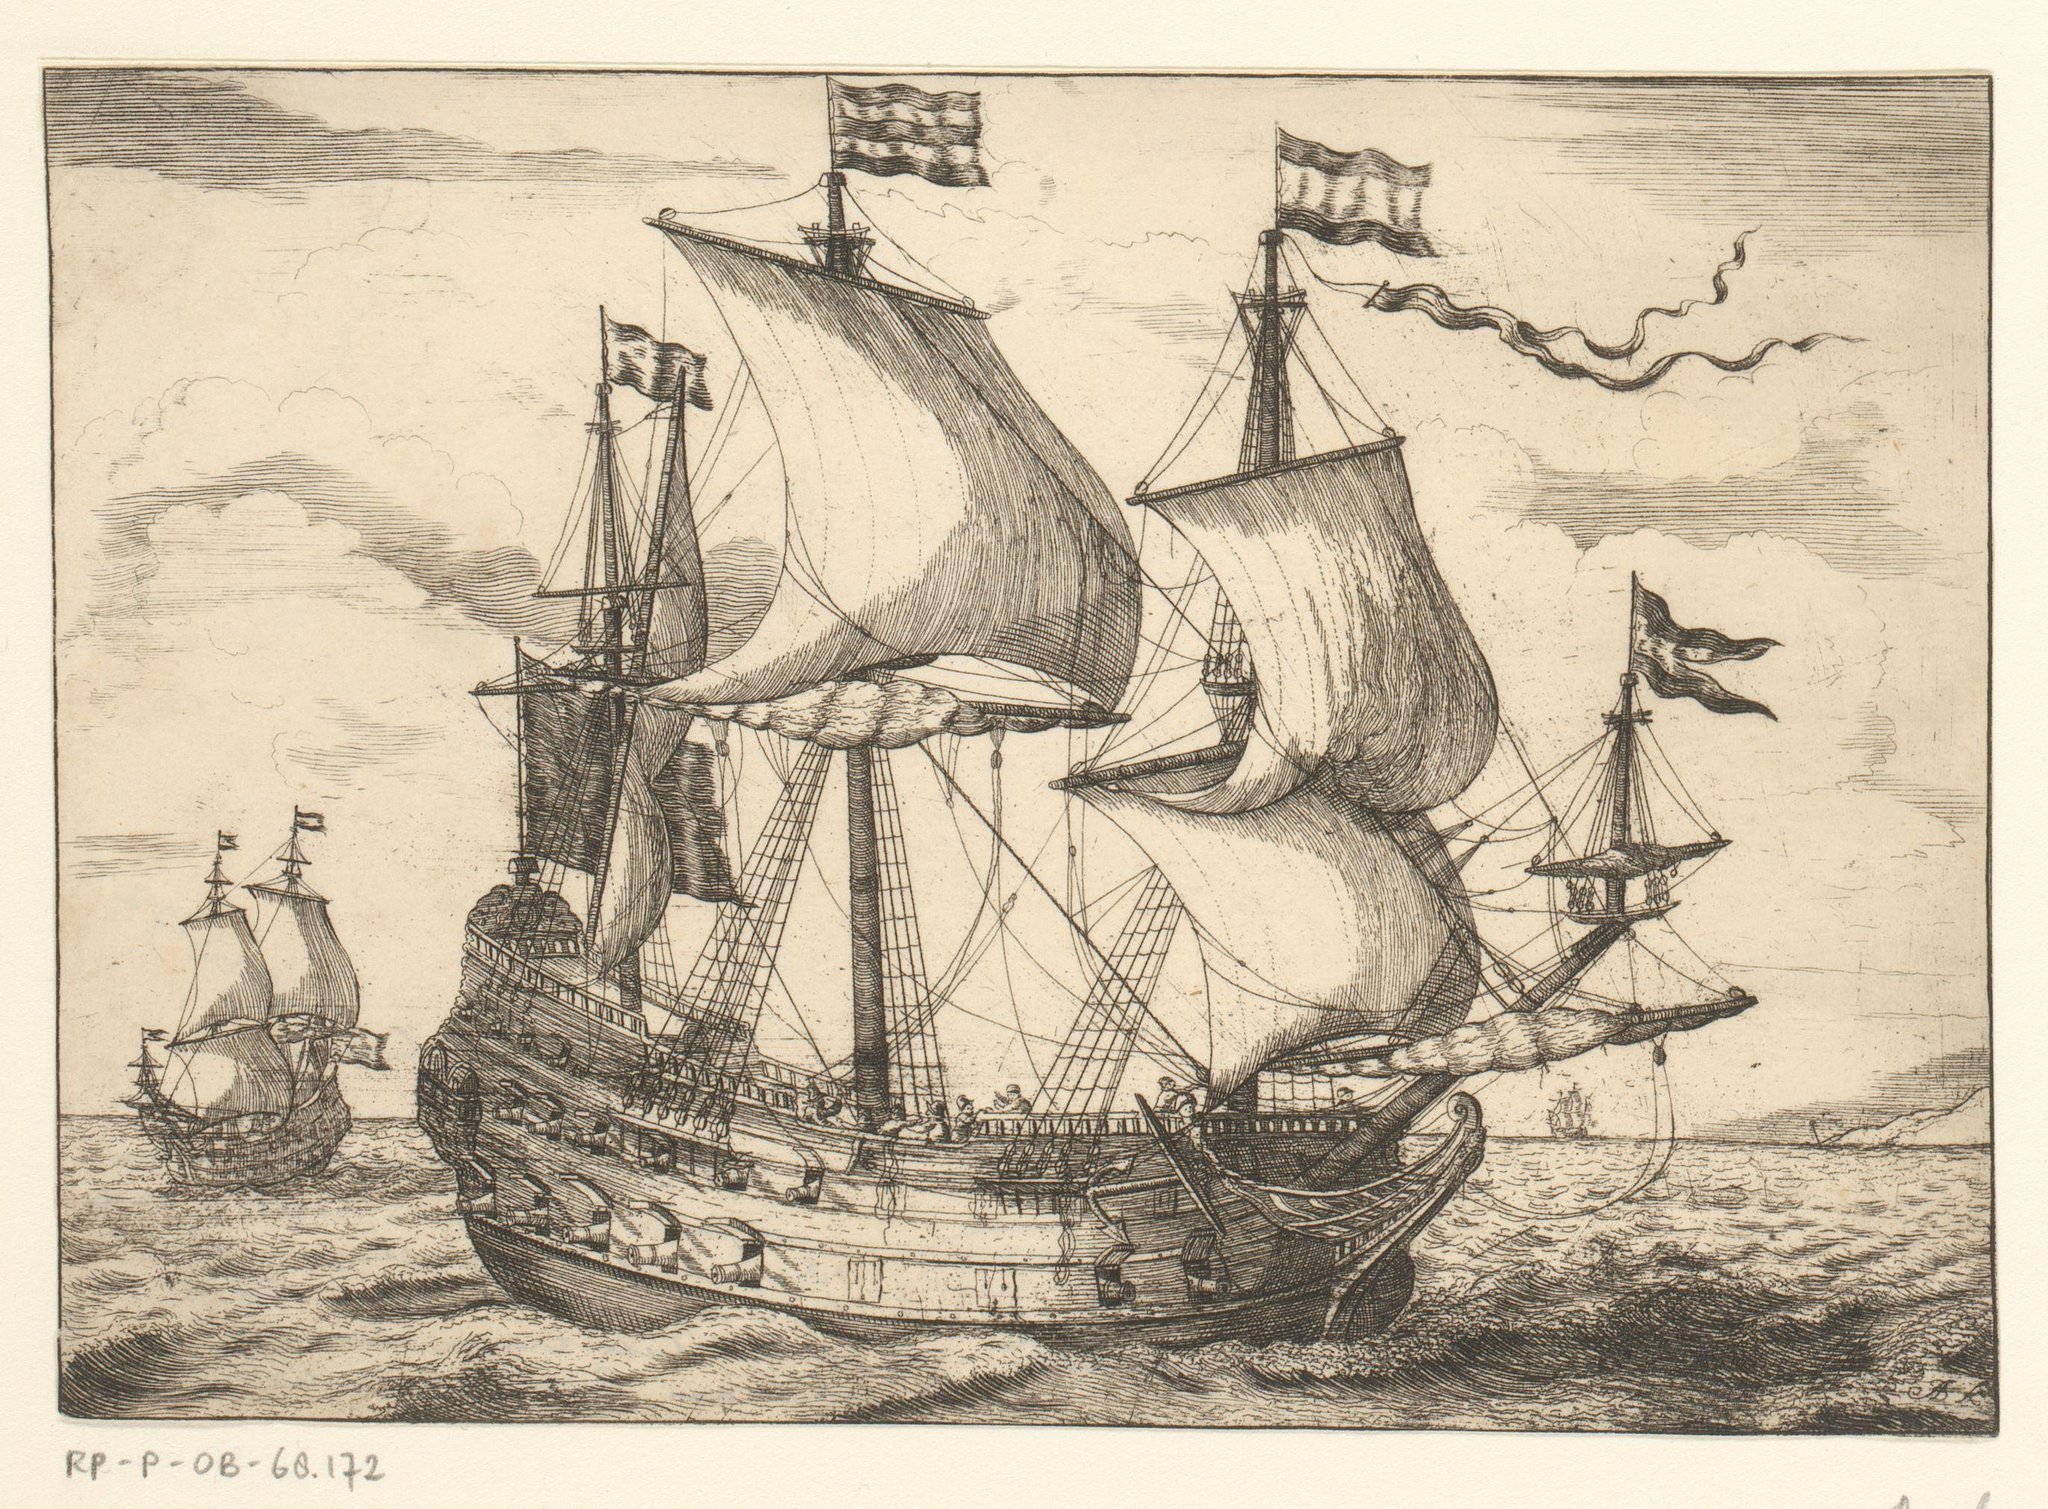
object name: print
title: Oorlogsschepen op zee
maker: monogrammist abk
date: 1640-1660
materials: paper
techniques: etching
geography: northern netherlands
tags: sailing-ship, sailing-boat, sea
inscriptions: inscription: ‘Zie over het merk/ Weigels Kunstcatalog/ No. 21382. Onder welk no. aldaar/ een prent is beschreven, ditzelfde merk/ dragend als op deze plaatjes - i doch/ het is mij onverklaarbaar hoe Weigel/ er toe heeft kunnen komen die/ plaat van Bakhuyzen toe te schrijven.’, collector's mark: Lugt 2228